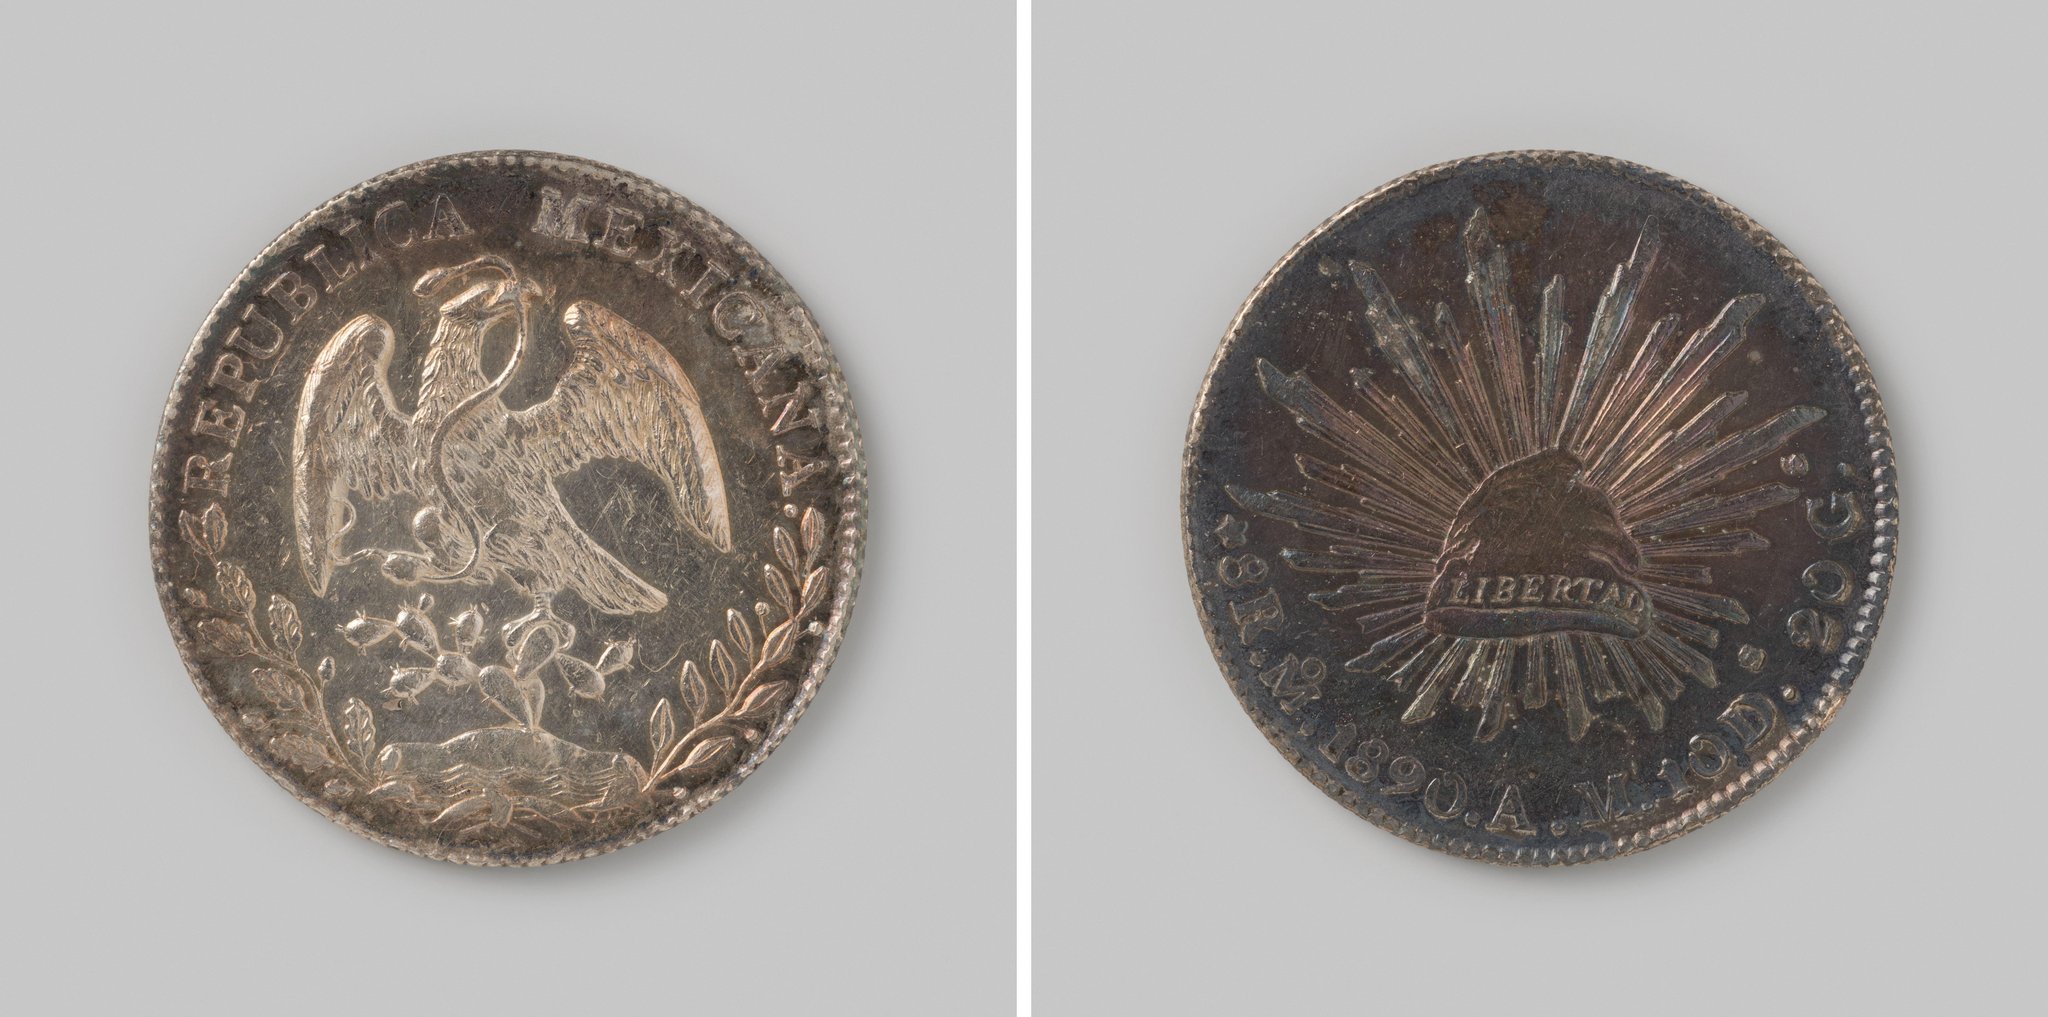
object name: peso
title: Peso of acht reaal uit Mexico, 1890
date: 1890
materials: silver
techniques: striking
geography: mexico city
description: Zilveren munt. Voorzijde: tussen twee samengebonden takken op cactusplant staande adelaar met gespreide vleugels met zijn kop naar rechts met in zijn bek een slang. Keerzijde: vrijheidshoed, waaruit stralen te voorschijn komen. In omschrift waarde-aanduiding: 8R en muntplaats-aanduiding: Mo [=Mexico] met jaartal linksonder. Kabelrand.